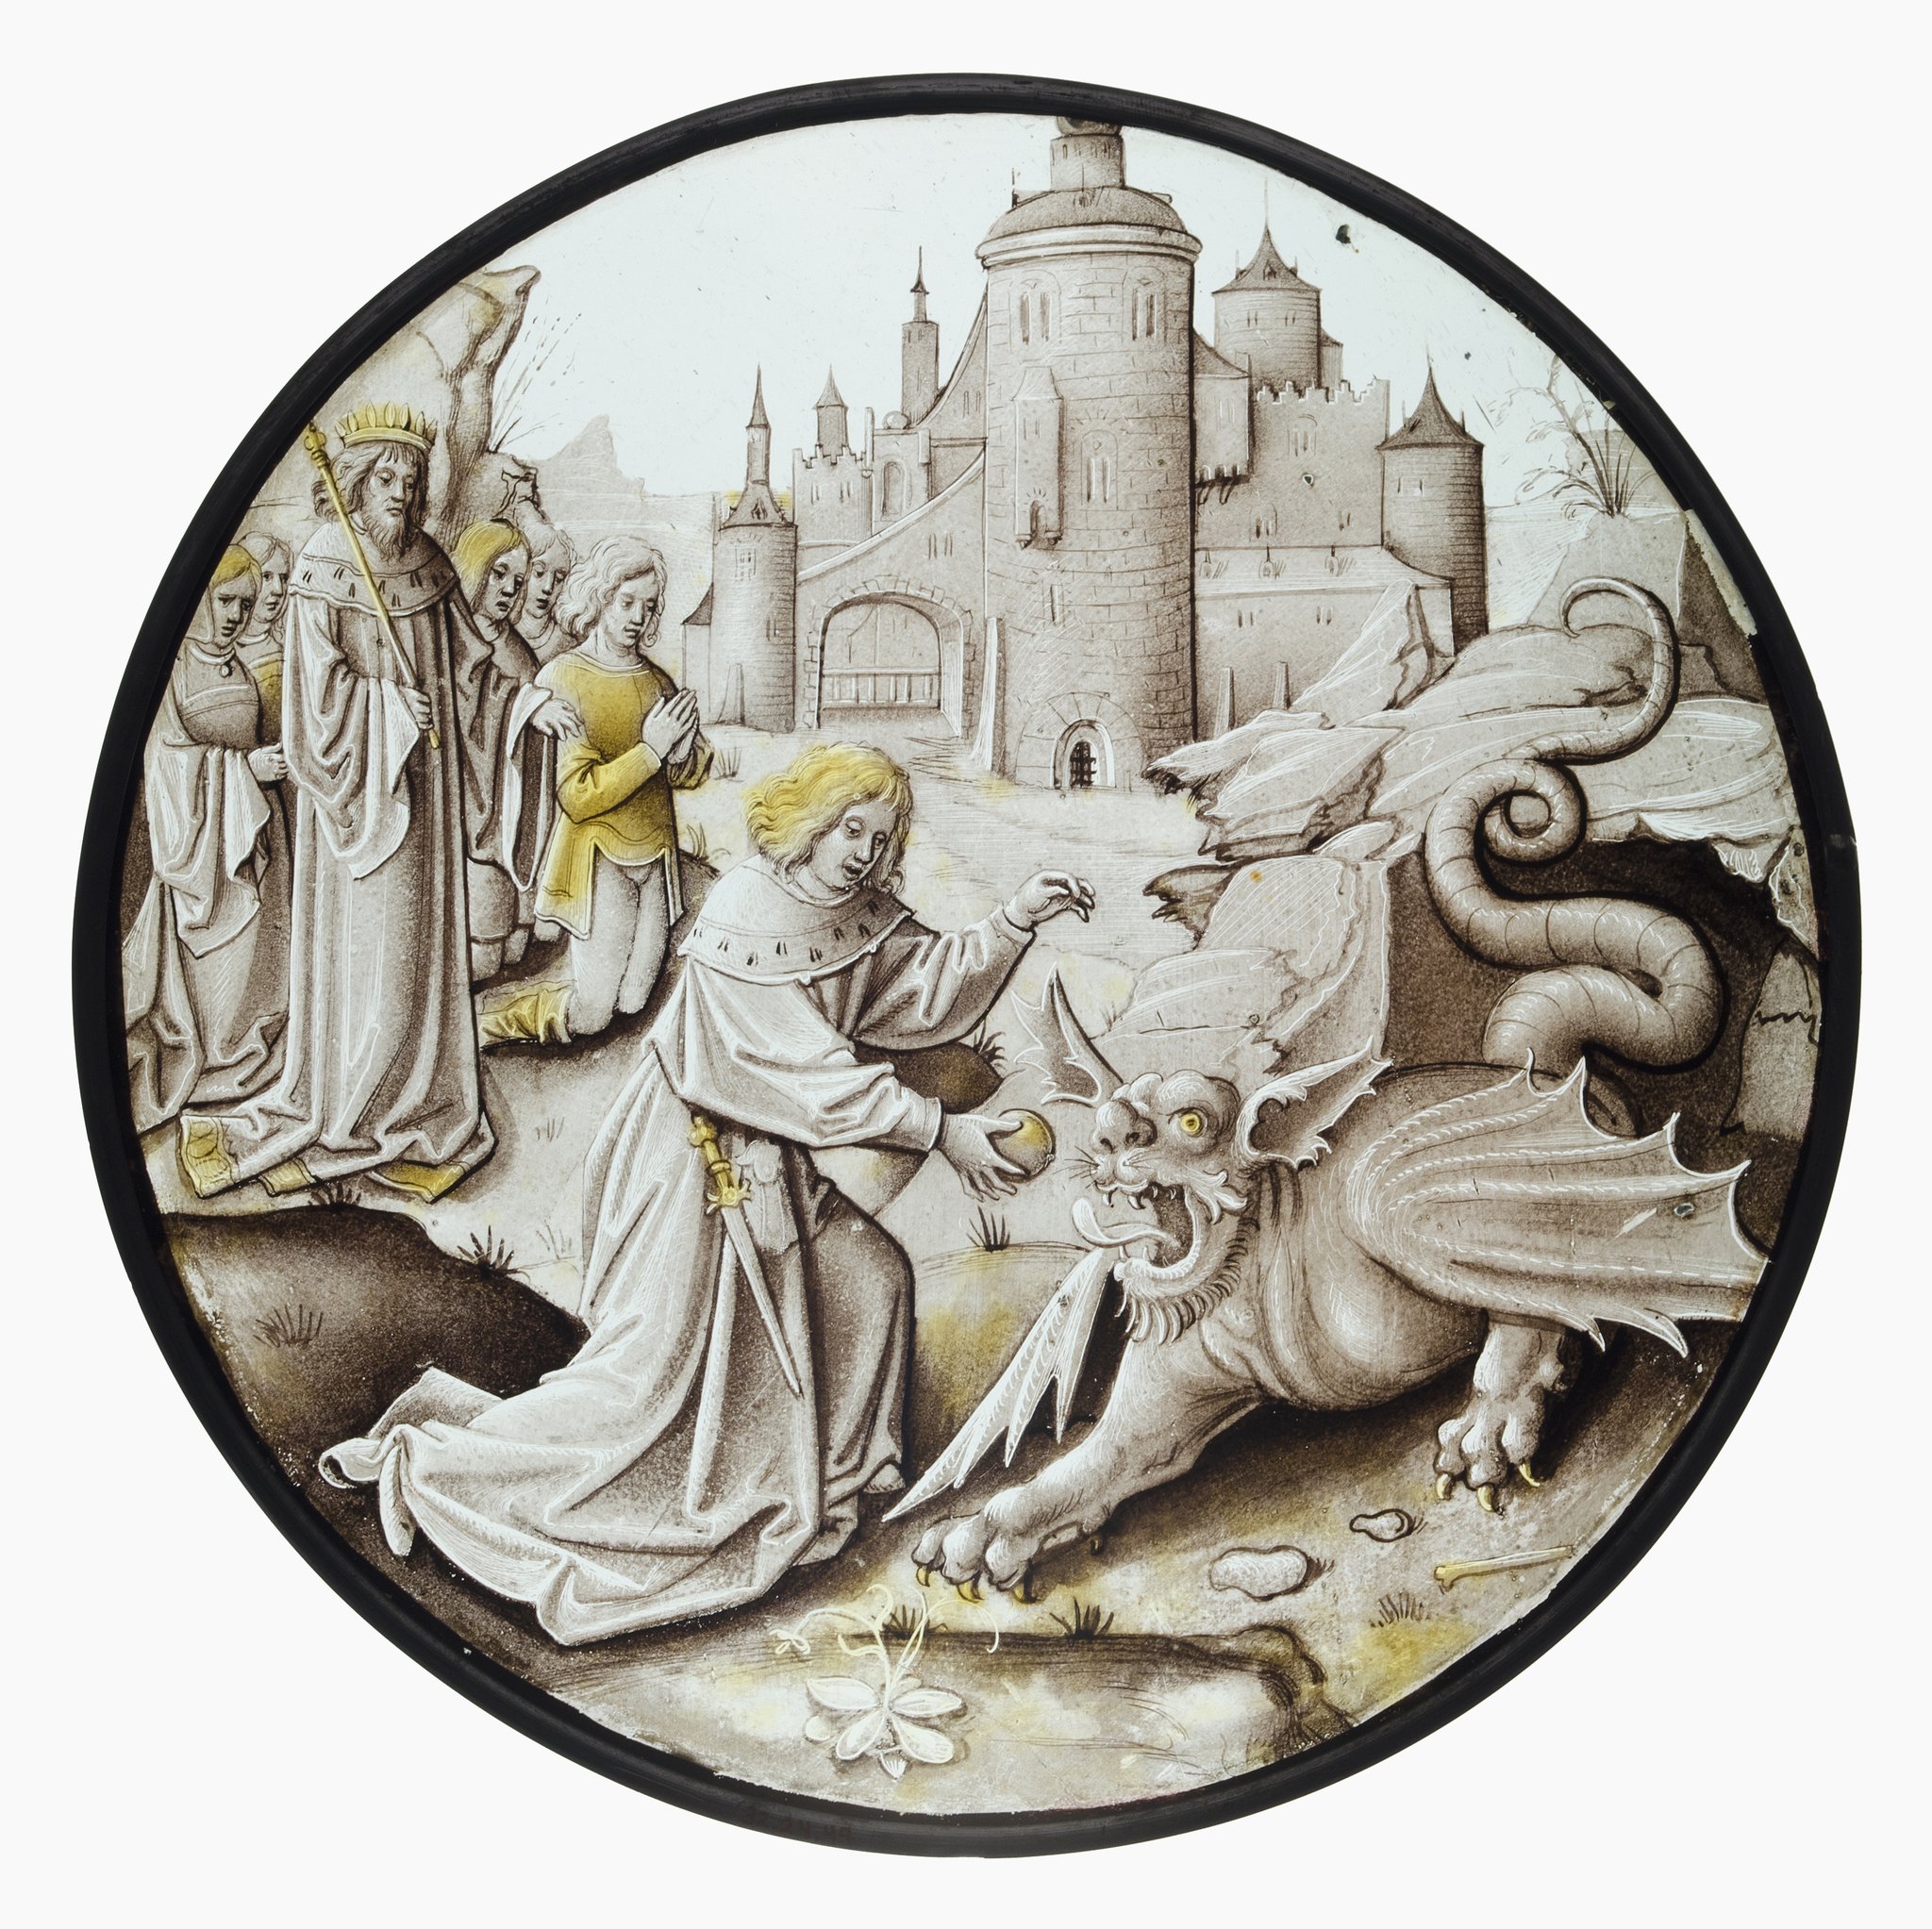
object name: roundel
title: Roundel with Daniel Slaying the Dragon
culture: south netherlandish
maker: pseudo-ortkens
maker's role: artist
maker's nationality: south netherlandish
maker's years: 1500-1530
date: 1520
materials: glass, paint, pigment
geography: netherlands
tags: castles,men,dragons